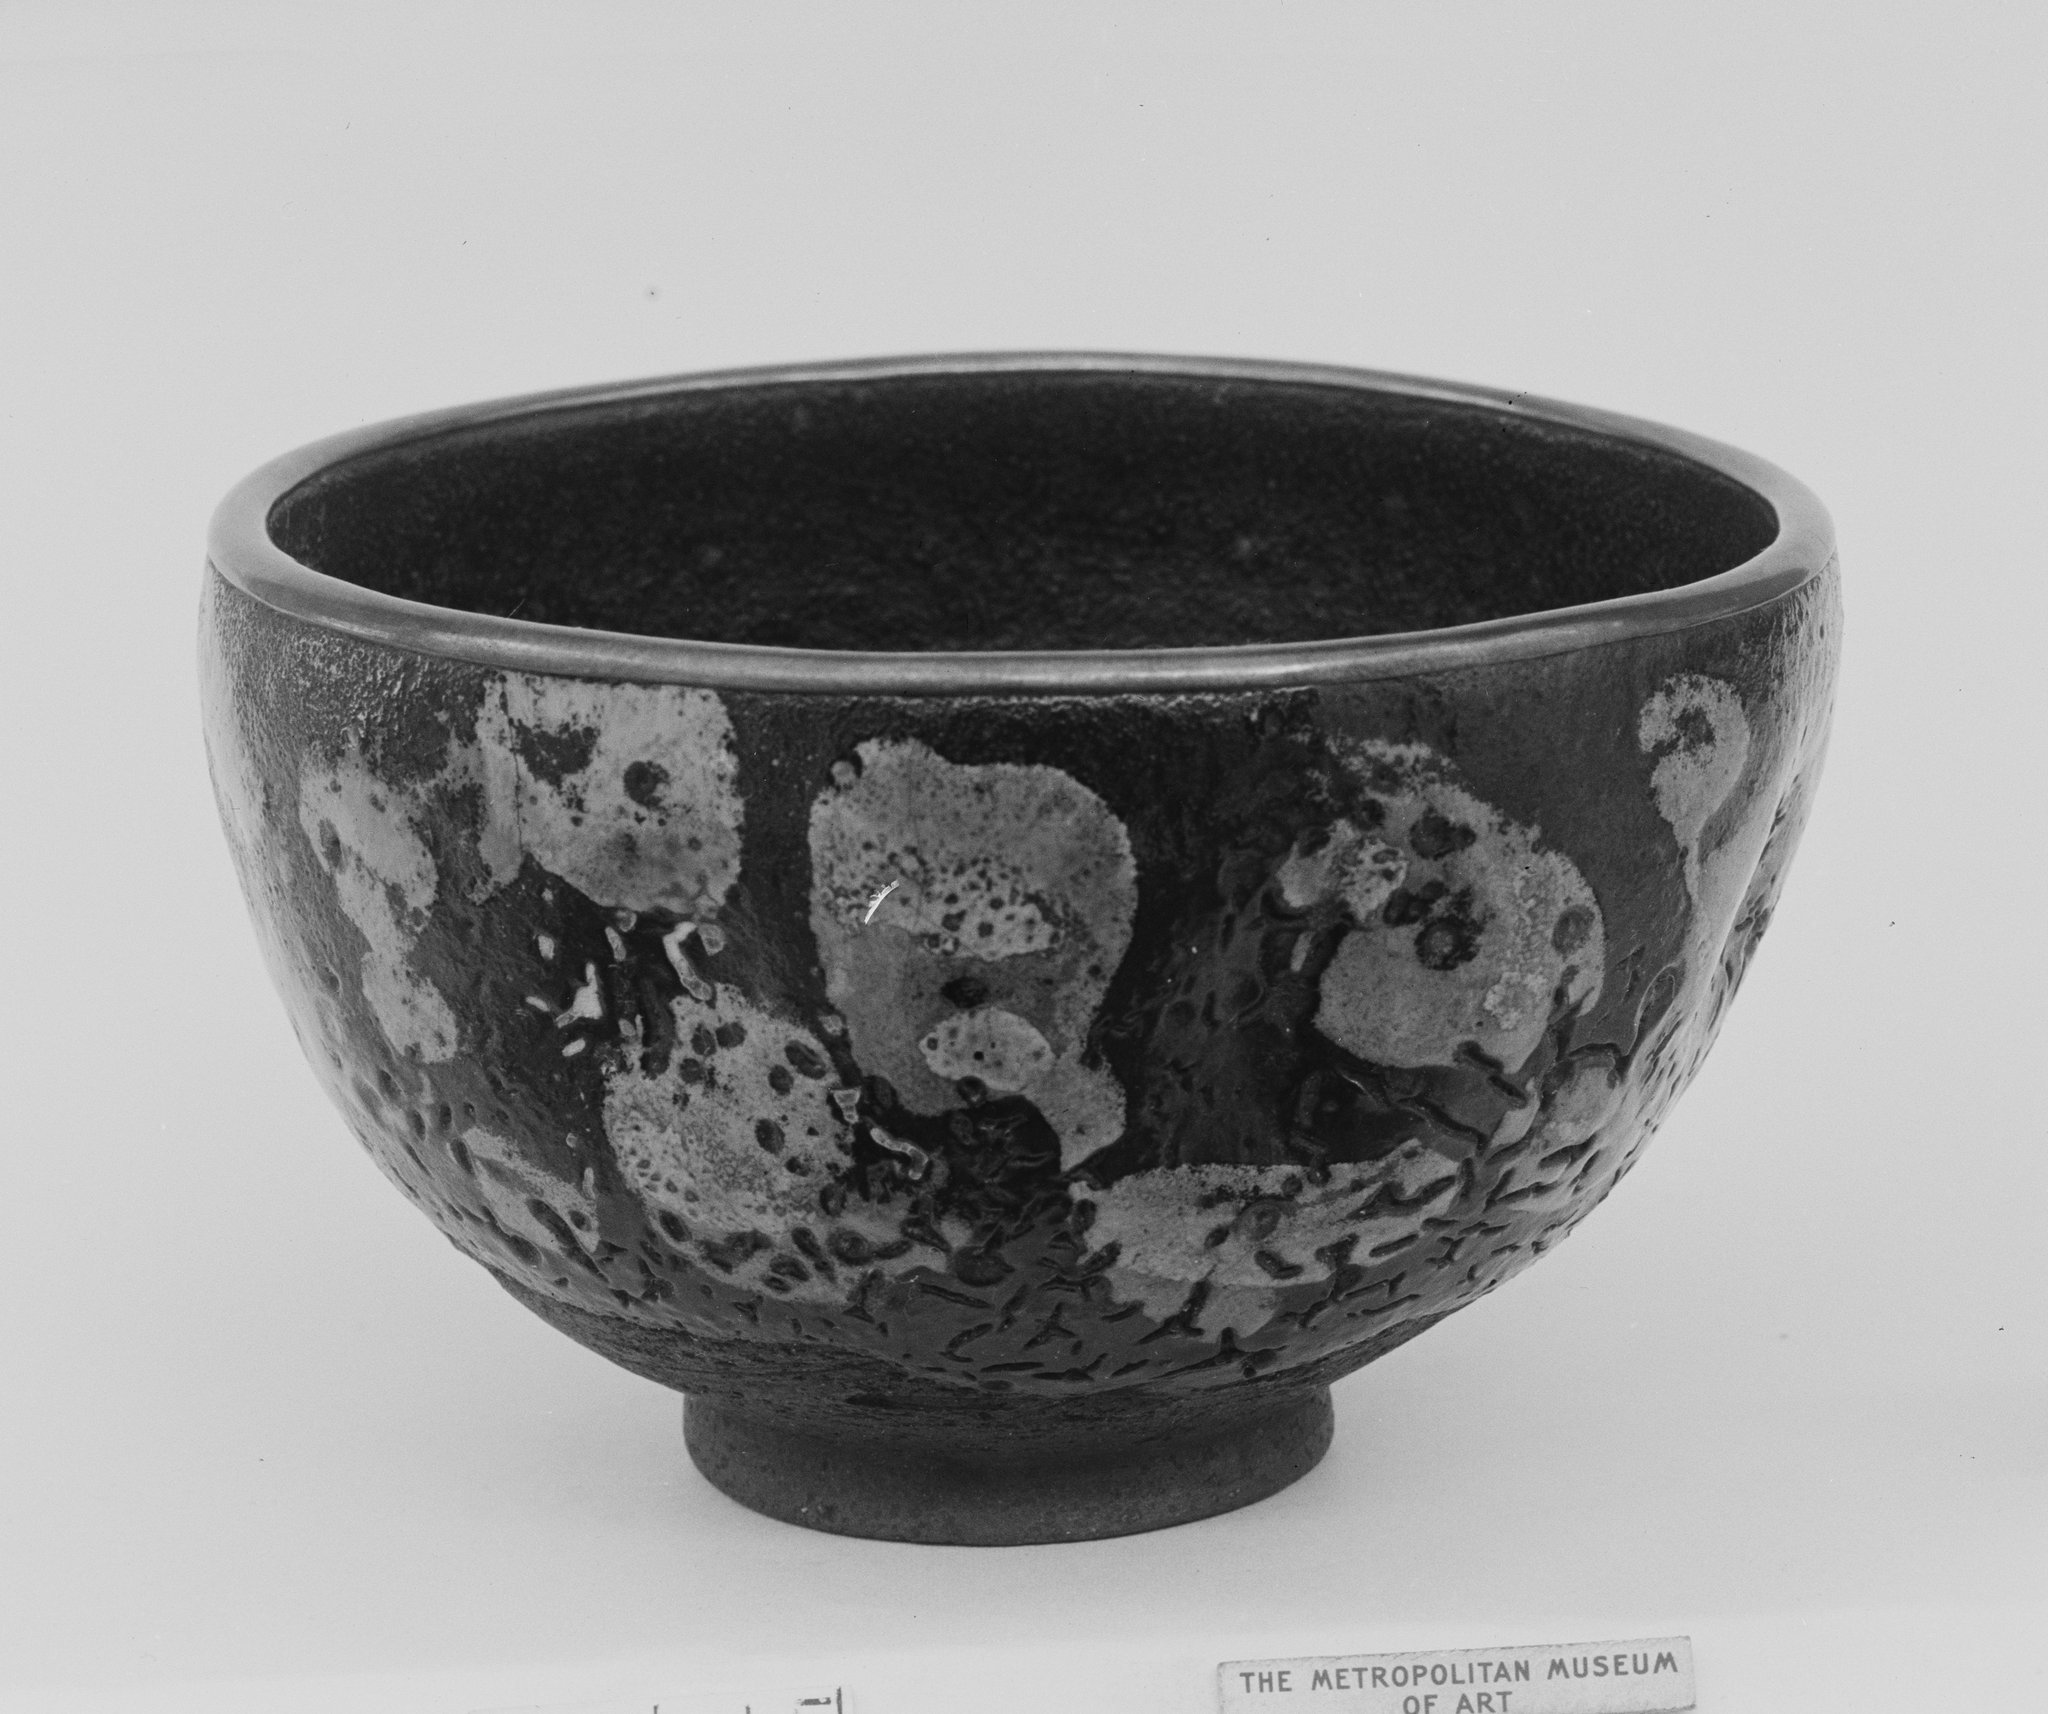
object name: bowl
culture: japanese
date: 1801-1900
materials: clay, glaze